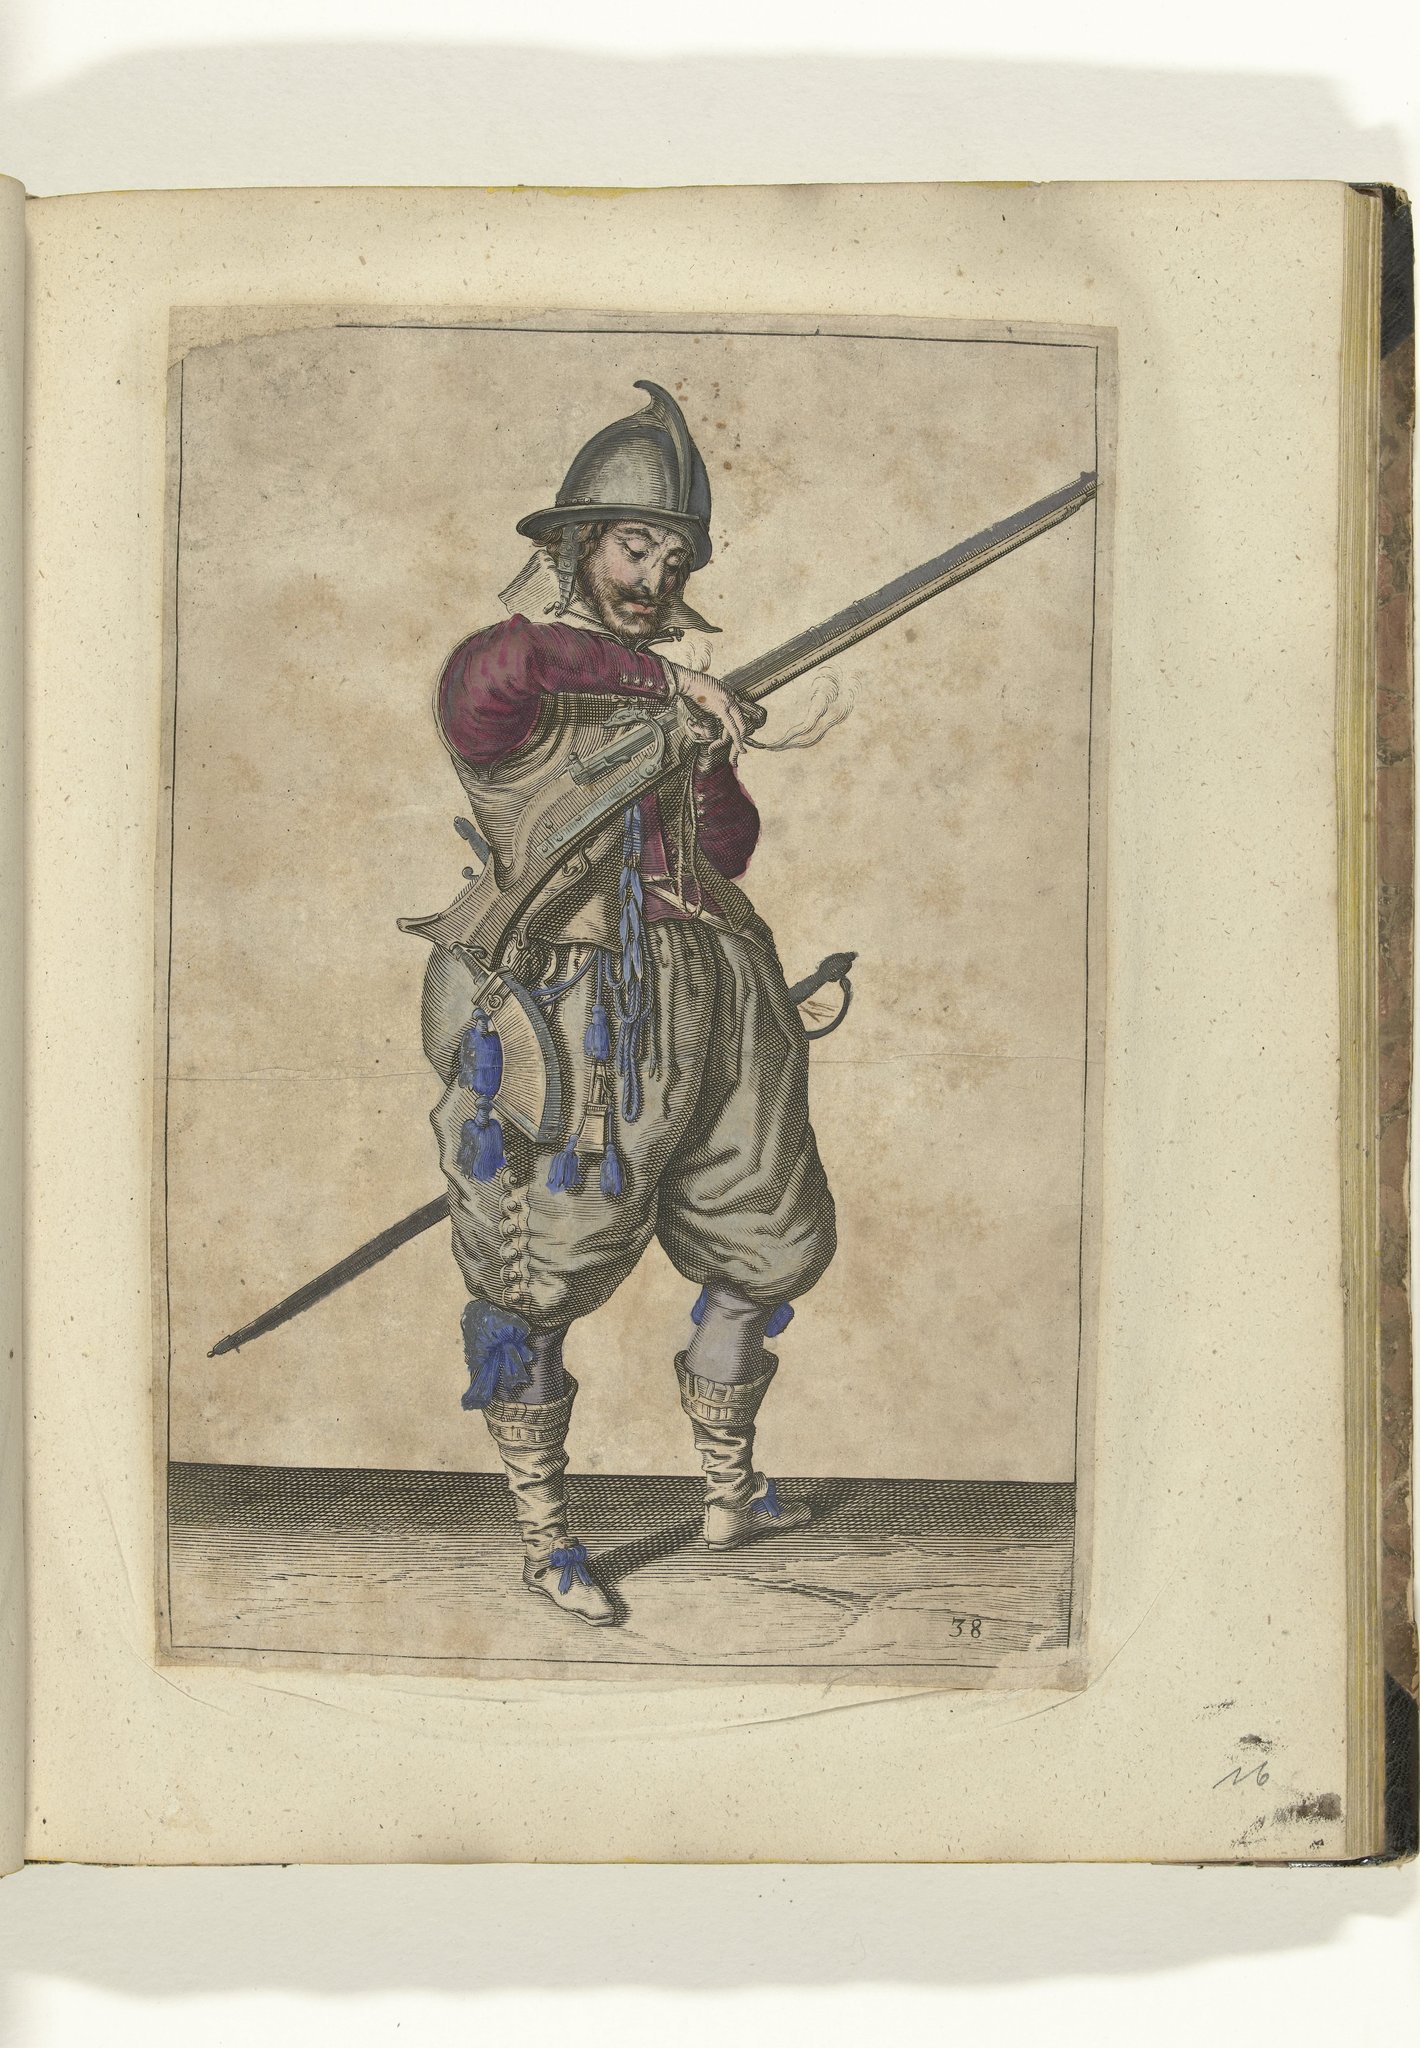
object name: print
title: Soldaat op wacht met een roer die zijn lont pakt (nr. 38), ca. 1600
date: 1597-1608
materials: paper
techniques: engraving, hand coloring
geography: northern netherlands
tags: the hague, maurice (prince of orange), handling of weapons ~ military training, weapons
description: Een soldaat op wacht, ten voeten uit, naar rechts, die een roer (een bepaald type vuurwapen) met zijn linkerhand vasthoudt. In zijn linkerhand behalve het roer ook een brandende lont (nr. 38), ca. 1600. Met zijn rechterhand pakt hij deze lont. Het gaat dus om dezelfde positie als degene die op de vijfde prent van de serie getoond wordt. Plaat 38 in de instructies voor het hanteren van de roer: Shorte instruction upon the contrefaictinges, touching the right use of calivers. Onderdeel van de illustraties in een Engelse editie van J. de Gheyns Wapenhandelinghe: J. de Gheyn, The exercise of armes for calivres, muskettes and pikes after the ordre of Maurits Prince of Orange, 's-Gravenhage 1608. Krijgswezen rond 1600.